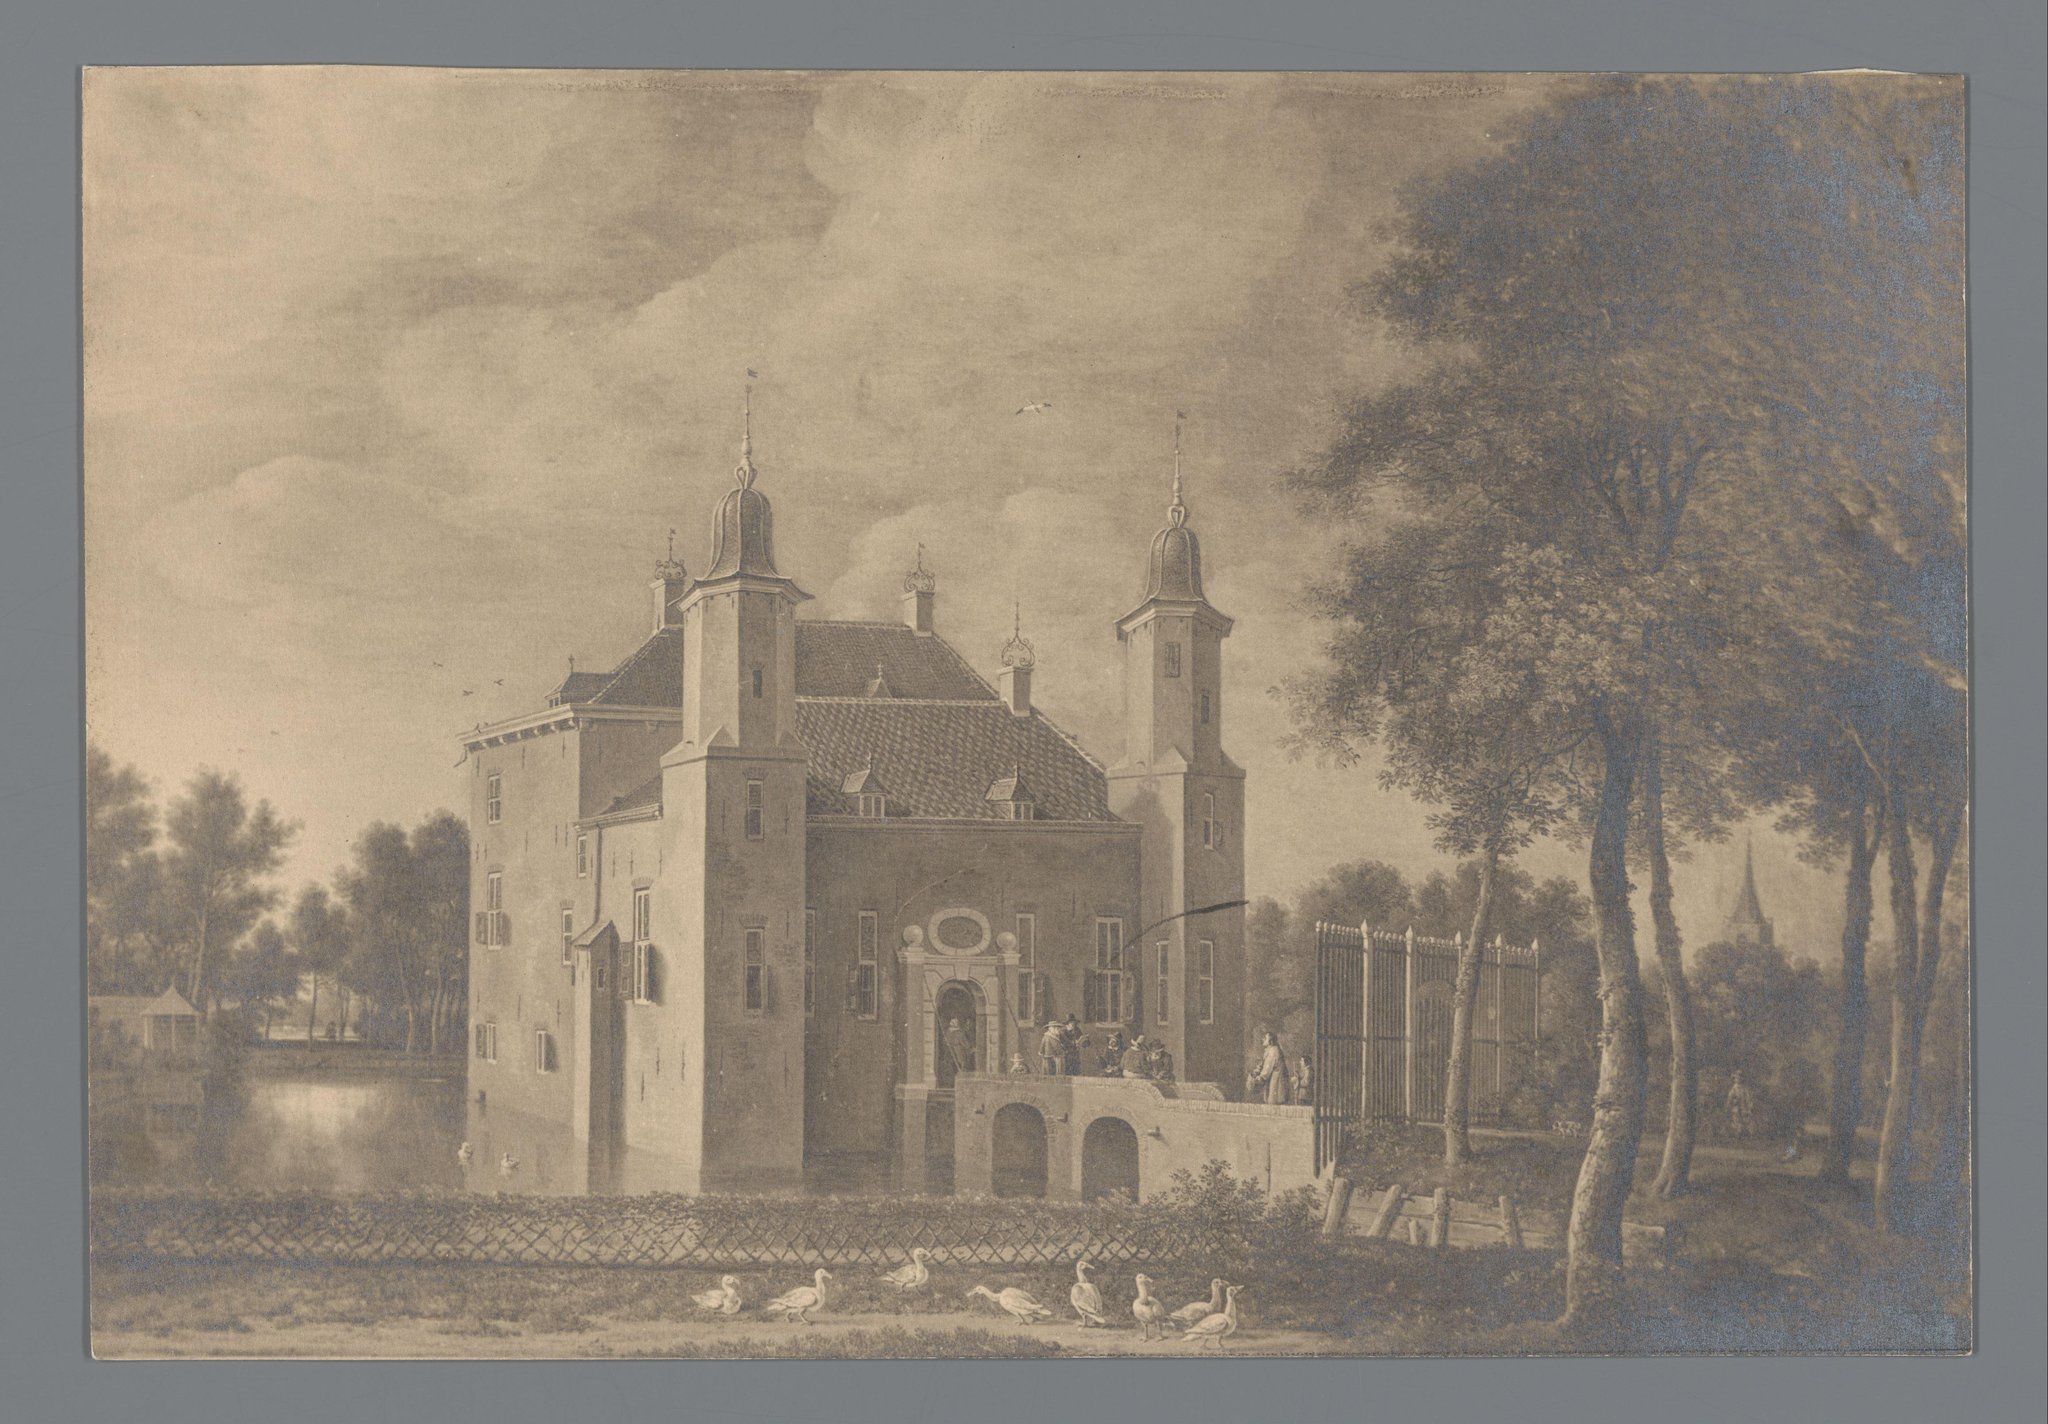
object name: reproduction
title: Fotoreproductie van een schilderij een schilderij van Landgoed Linschoten door Herman Saftleven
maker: Anonymous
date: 1900-1909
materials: photographic support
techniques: gelatin silver print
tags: landscape with tower or castle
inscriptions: collector's mark: Lugt 2228, inscription: ‘'09.140’, annotation: ‘Linschoten/ C. Pronck/ Geschenk Hr. J.A. van [Voorthuijzen]’